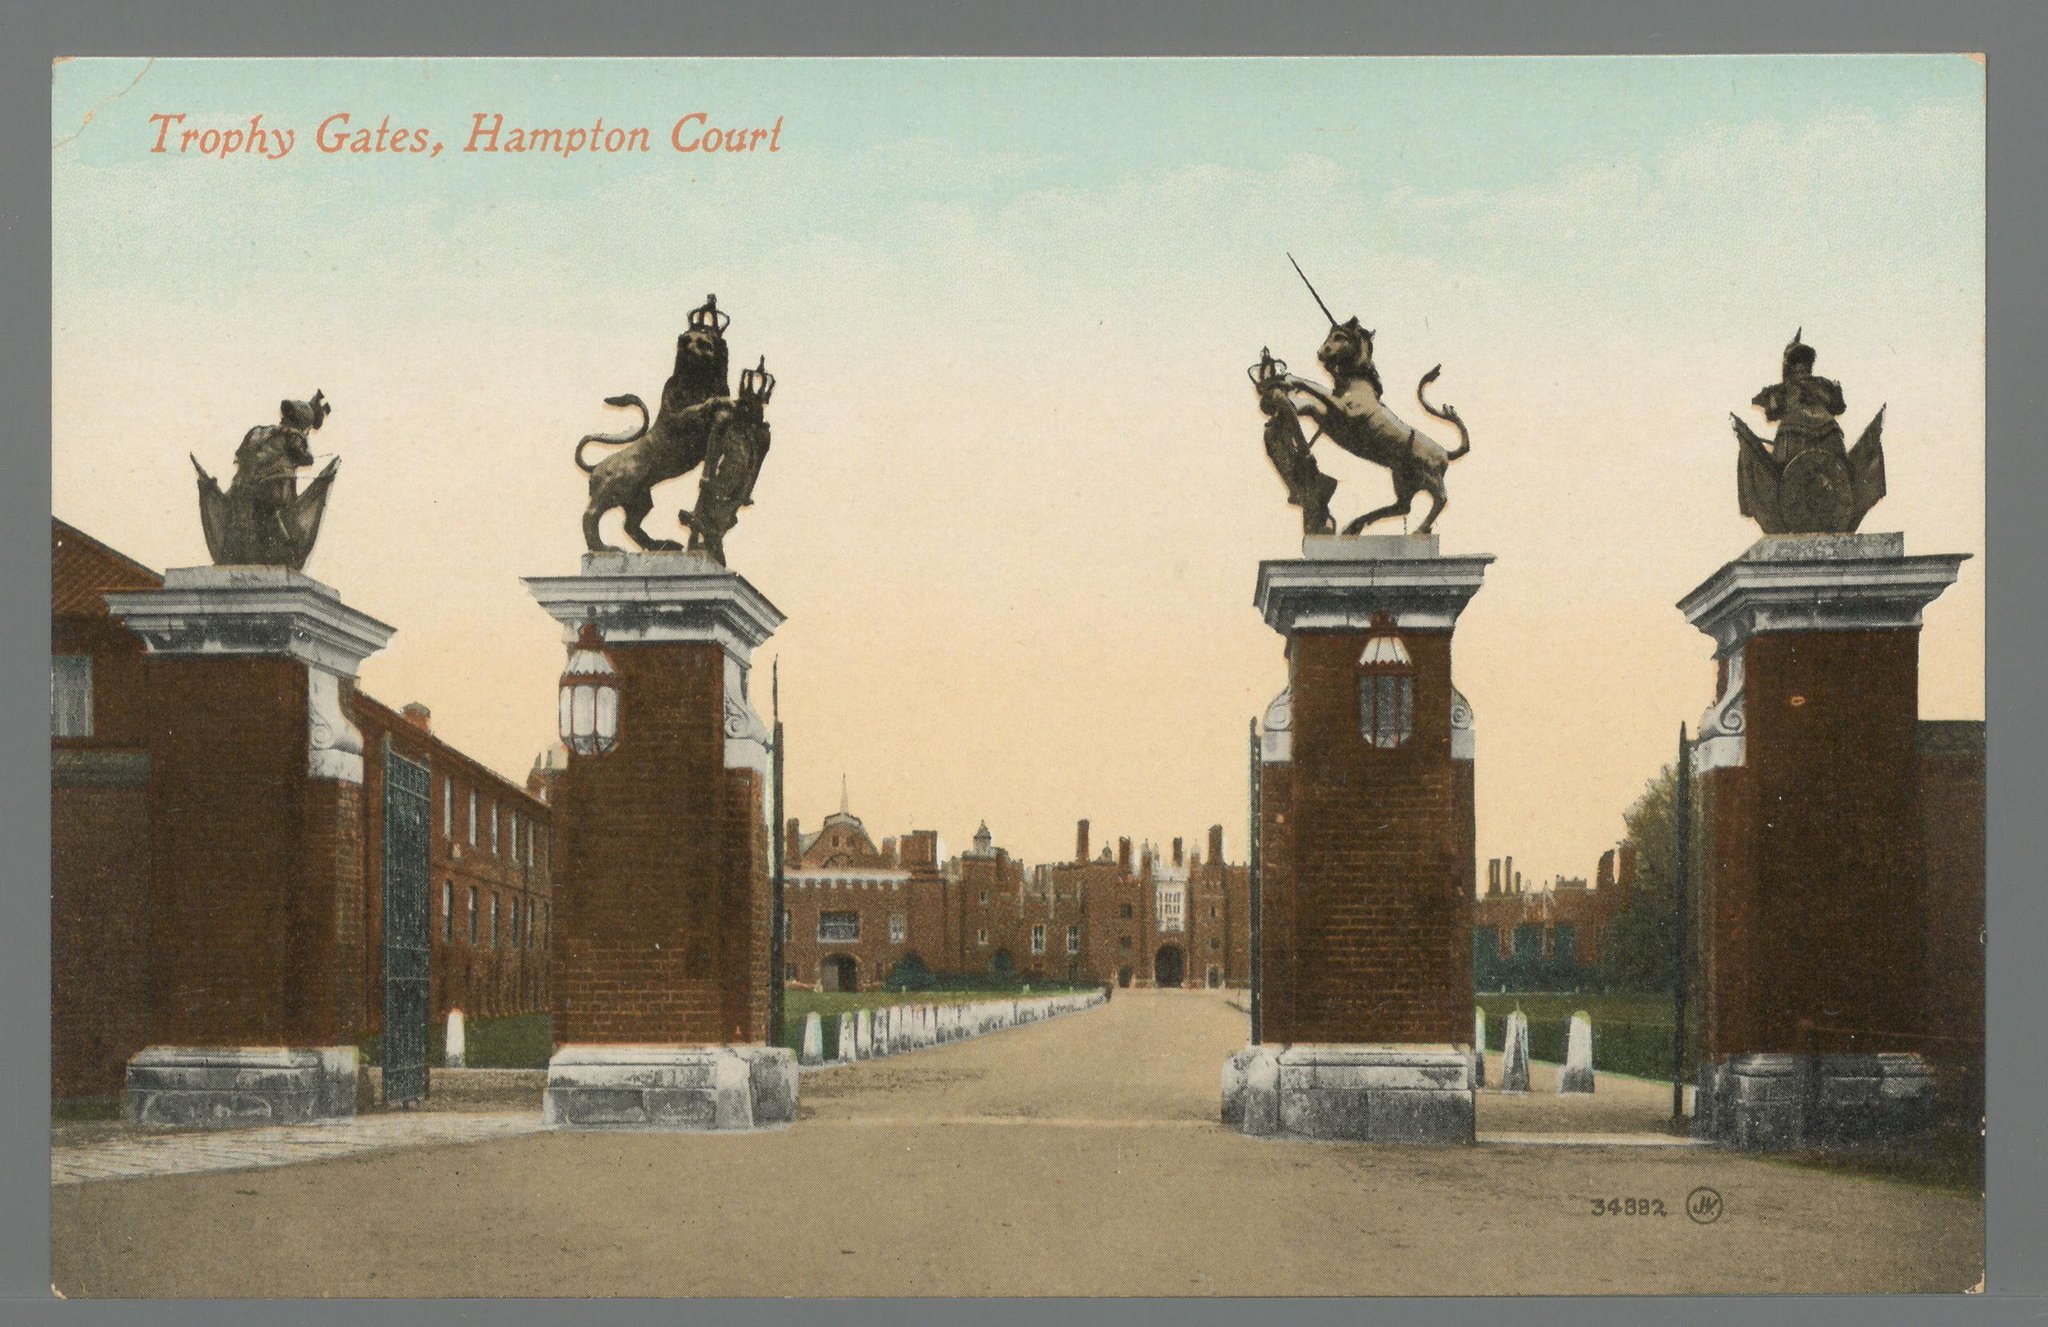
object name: photomechanical print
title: Valentine's Series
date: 1902-1930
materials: cardboard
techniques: lithograph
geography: great britain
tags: palace, gate, entrance